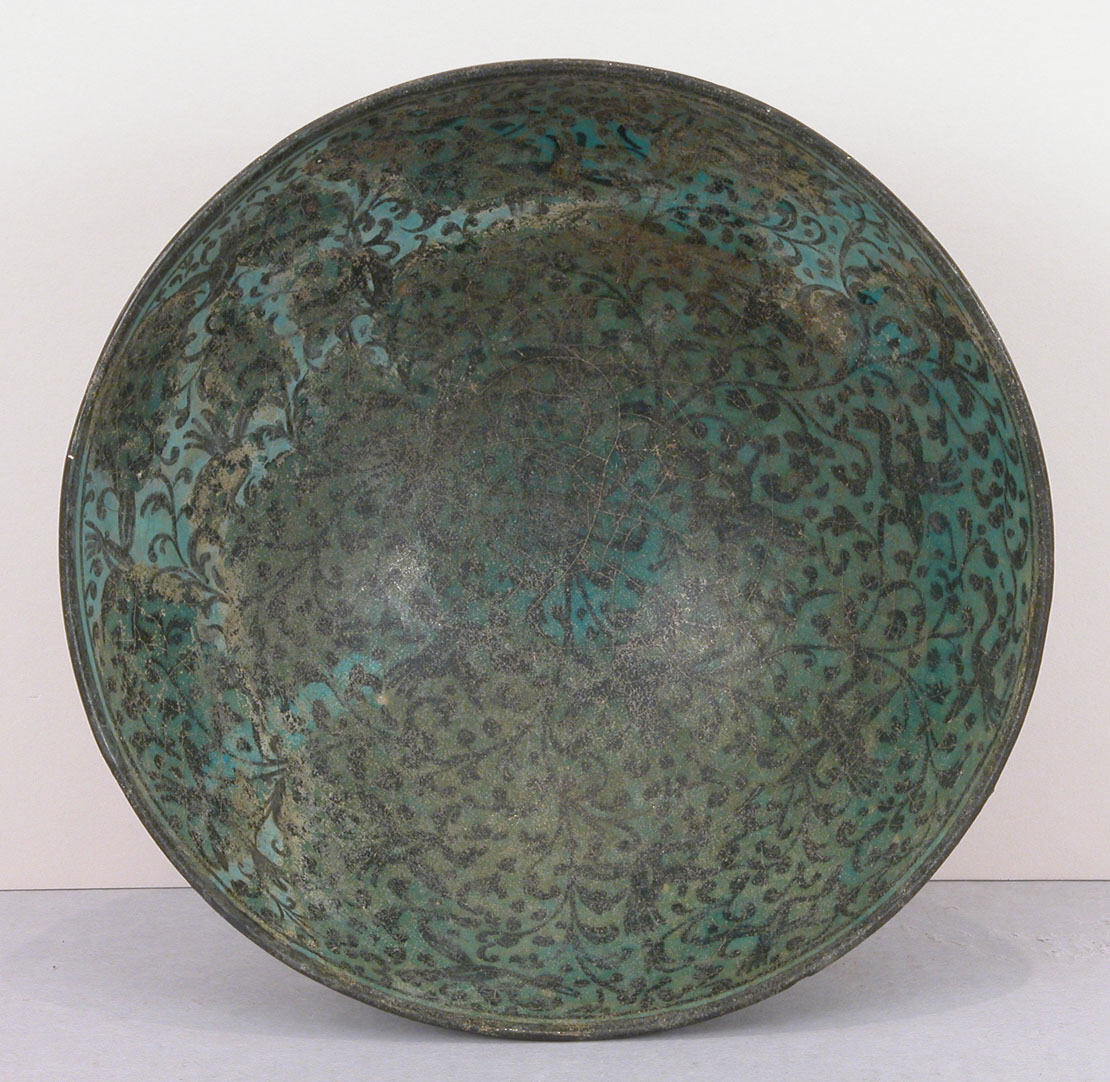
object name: bowl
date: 1201-1300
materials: stonepaste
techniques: painting, underglaze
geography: syria